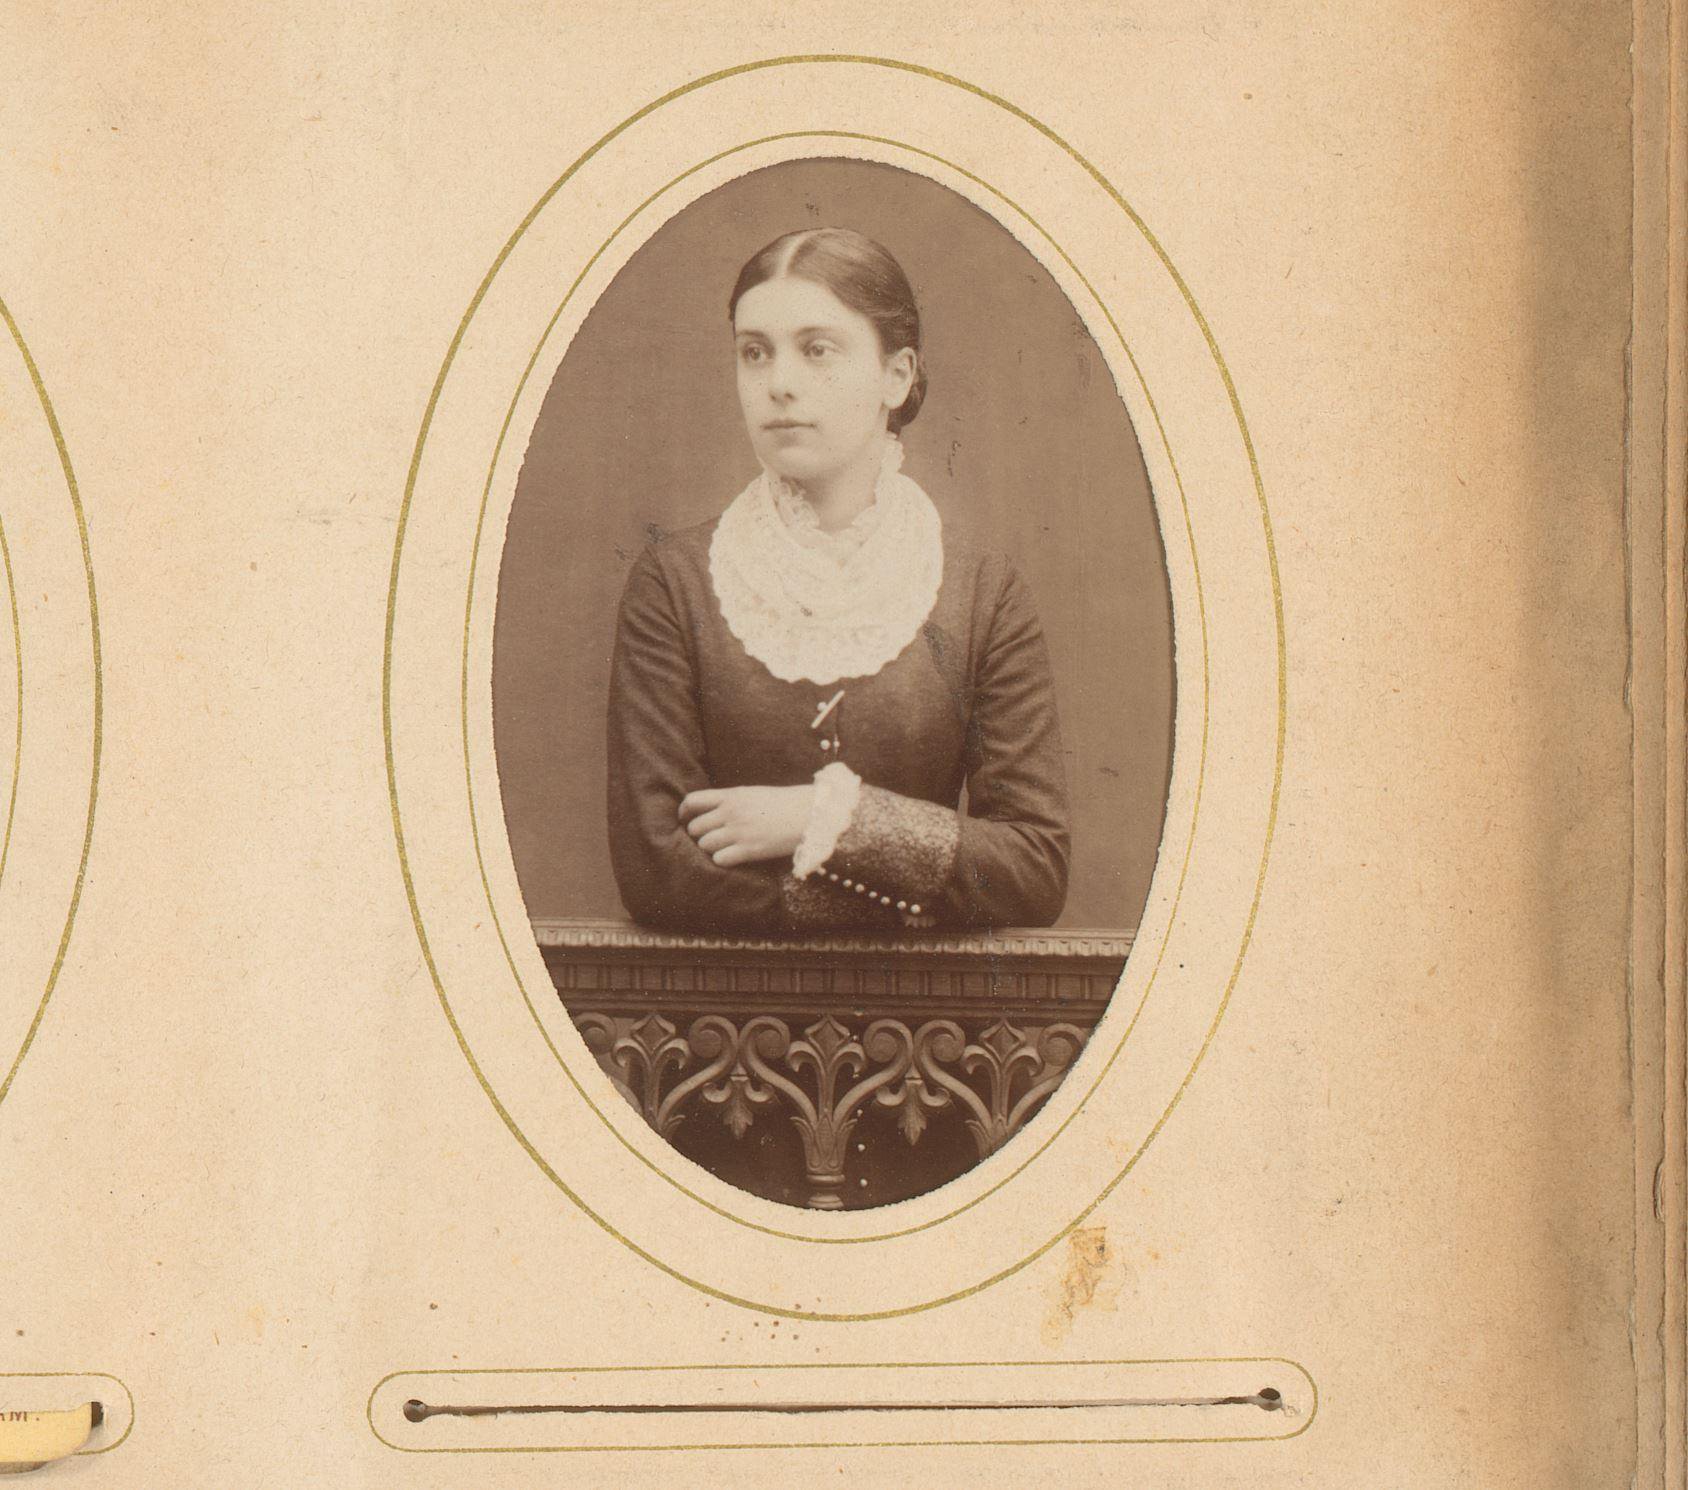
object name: album leaf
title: Portret van een staande jonge vrouw, leunend op een balustrade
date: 1865-1903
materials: cardboard, photographic support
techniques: albumen print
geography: the hague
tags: adolescent, young woman, maiden, historical persons - bb - woman, balustrade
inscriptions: inscription: ‘De Lavieter & Co./ PHOTOGRAPHES DE S. M. DE ROI/ ET DE SON ALTESSE ROYALE/ LE PRINCE ALEXANDRE/ DES PAYS-BAS./ LA HAYE.’